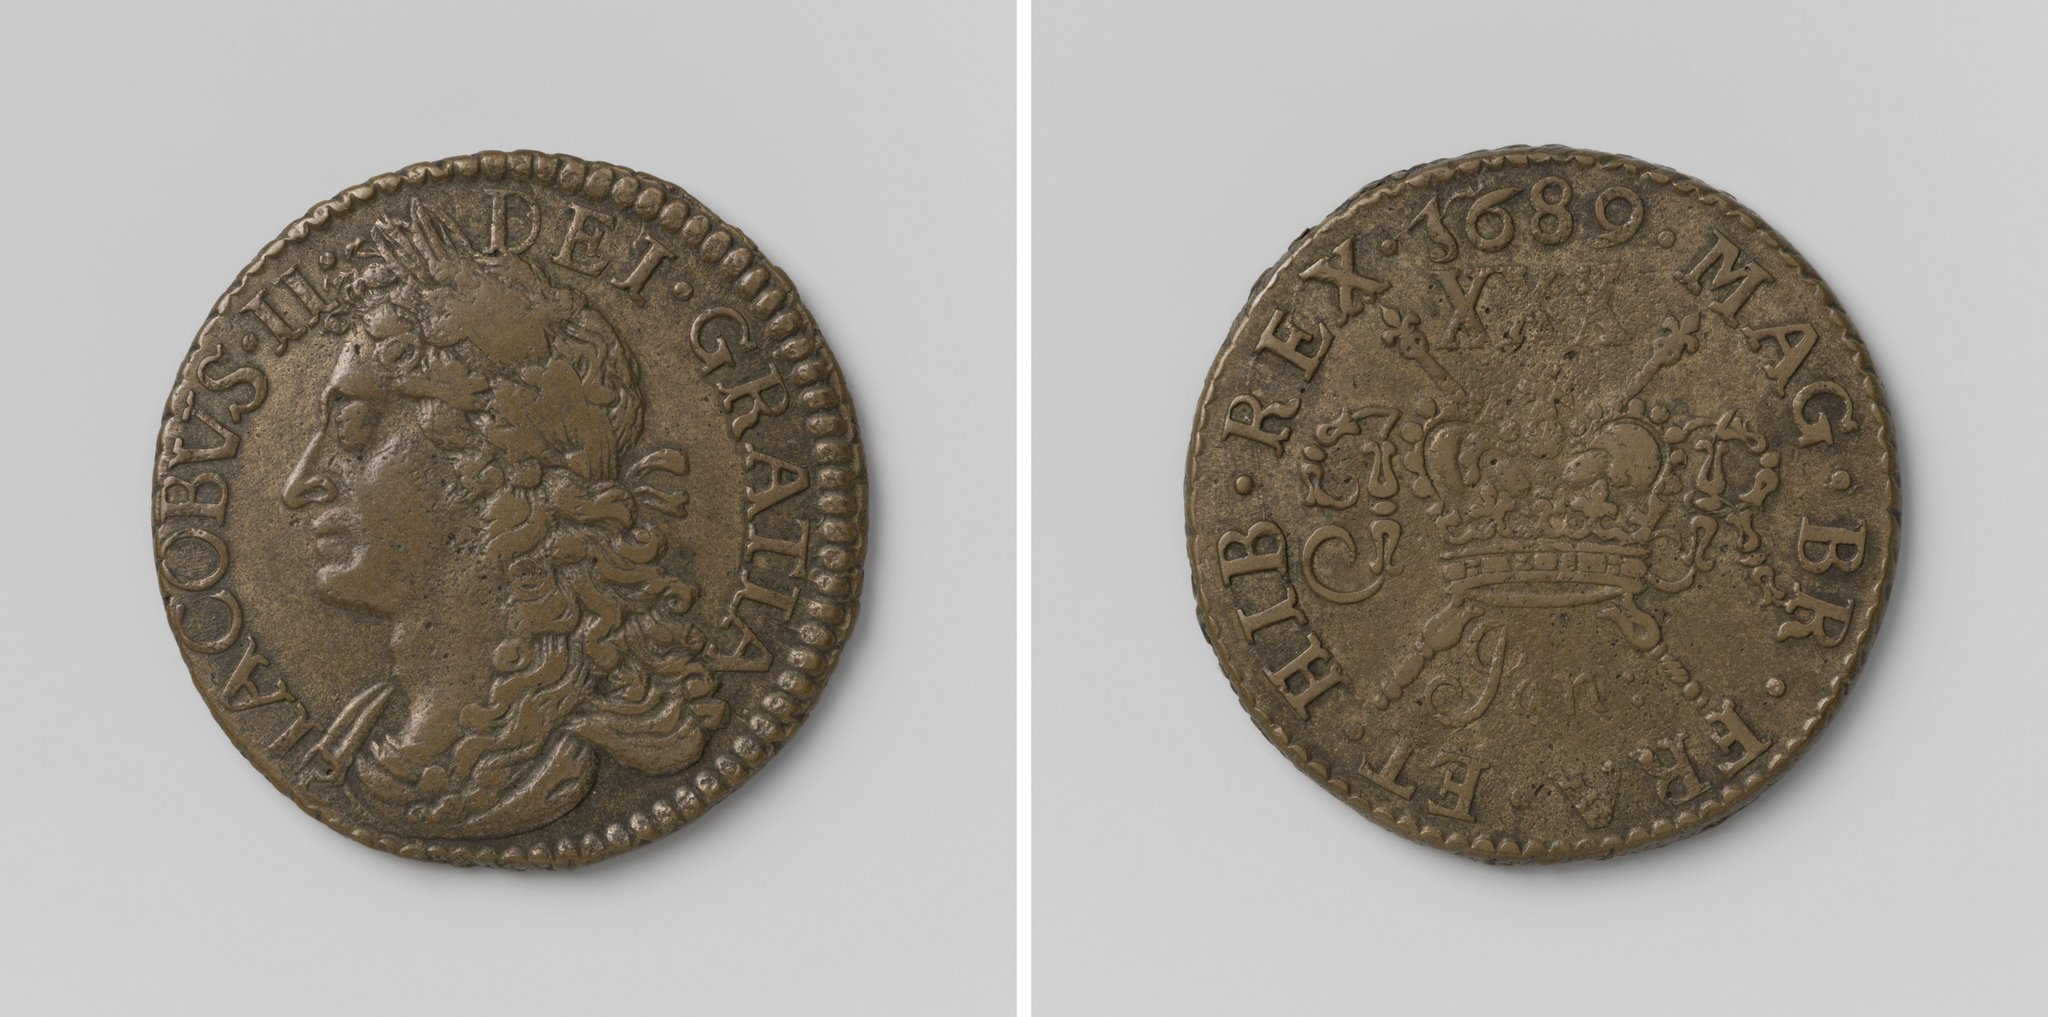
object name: halve crown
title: Halve crown, noodmunt van Jacobus II, koning van Engeland, uit januari 1689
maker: Anonymous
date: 1601-1689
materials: copper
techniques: striking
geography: ireland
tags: jacobus ii (koning van engeland en schotland)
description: Voorzijde: borststuk man met lauwerkrans binnen omschrift. Keerzijde: kroon, waardoor twee gekruiste scepters steken tussen monogram van letters J en R; boven kroon Romeinse cijfer XXX, onder kroon opschrift "Jan: " binnen omschrift